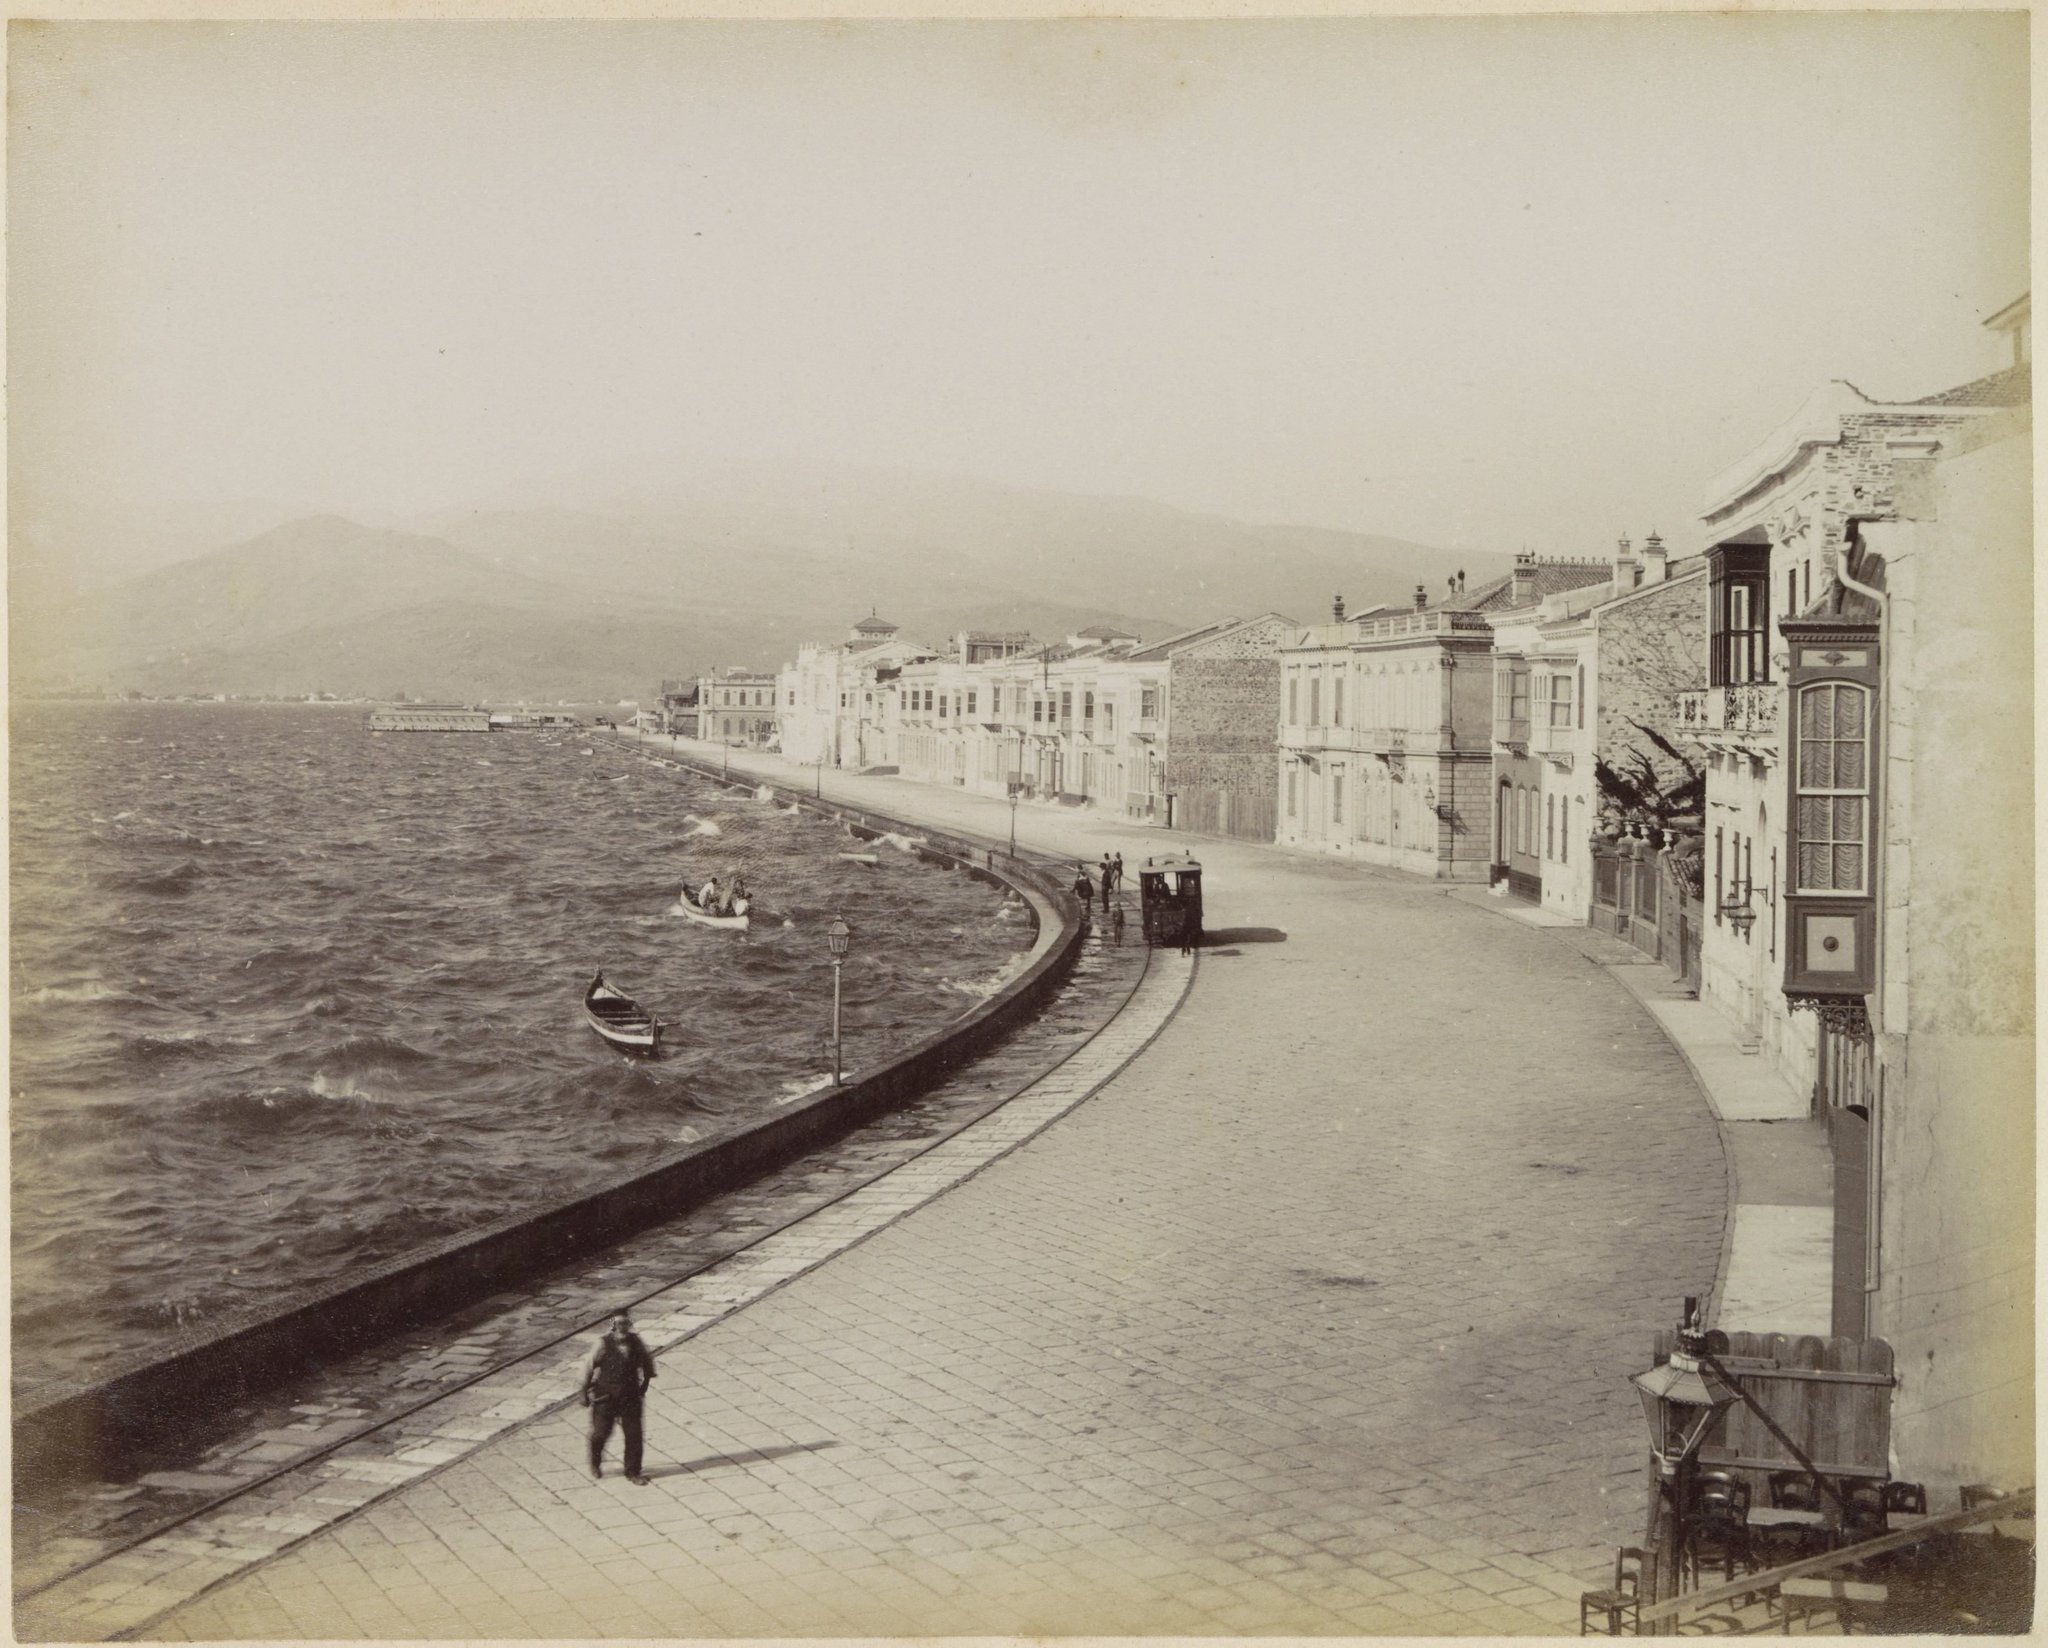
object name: photograph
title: Gezicht op de woelige zee en een kade in Smyrna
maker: Anonymous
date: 1880-1890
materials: paper, photographic support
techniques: albumen print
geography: smyrna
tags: tramway, tram, quay (+ city(-scape) with figures, staffage), sea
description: Onderdeel van Reisalbum met foto's van bezienswaardigheden in Frankrijk, Griekenland en Turkije.